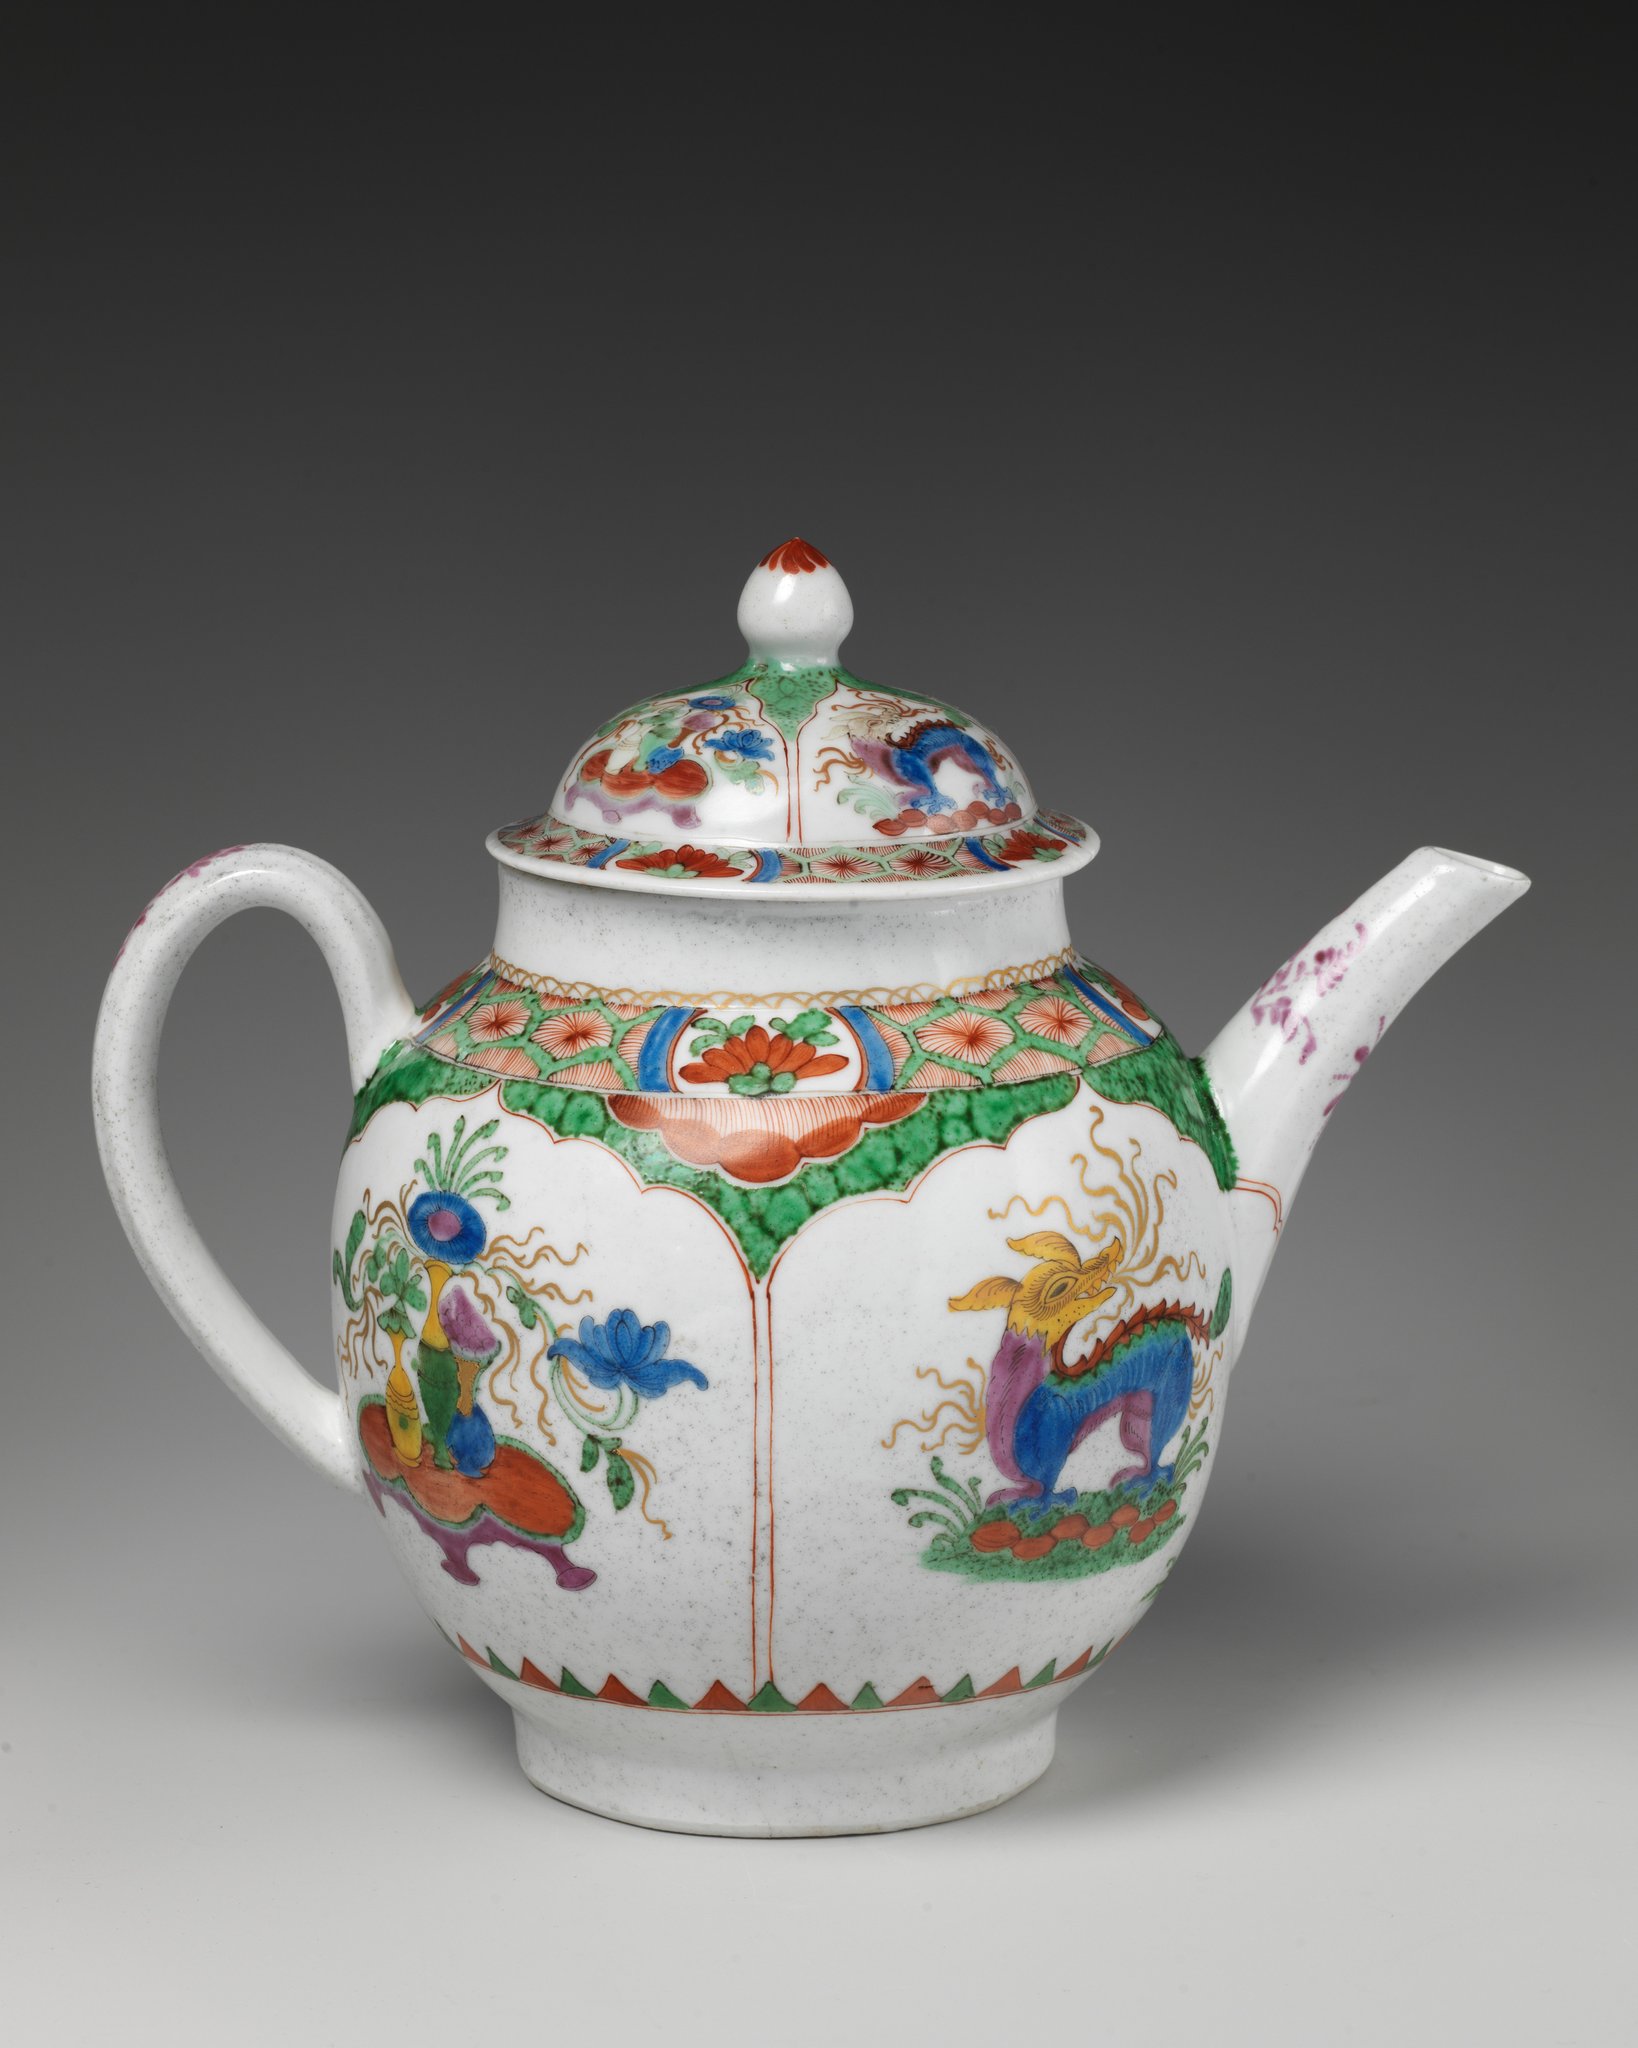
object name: teapot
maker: earls of plymouth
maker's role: factory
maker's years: 1768-1770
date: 1770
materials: enamel, hard paste porcelain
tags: animals,flowers